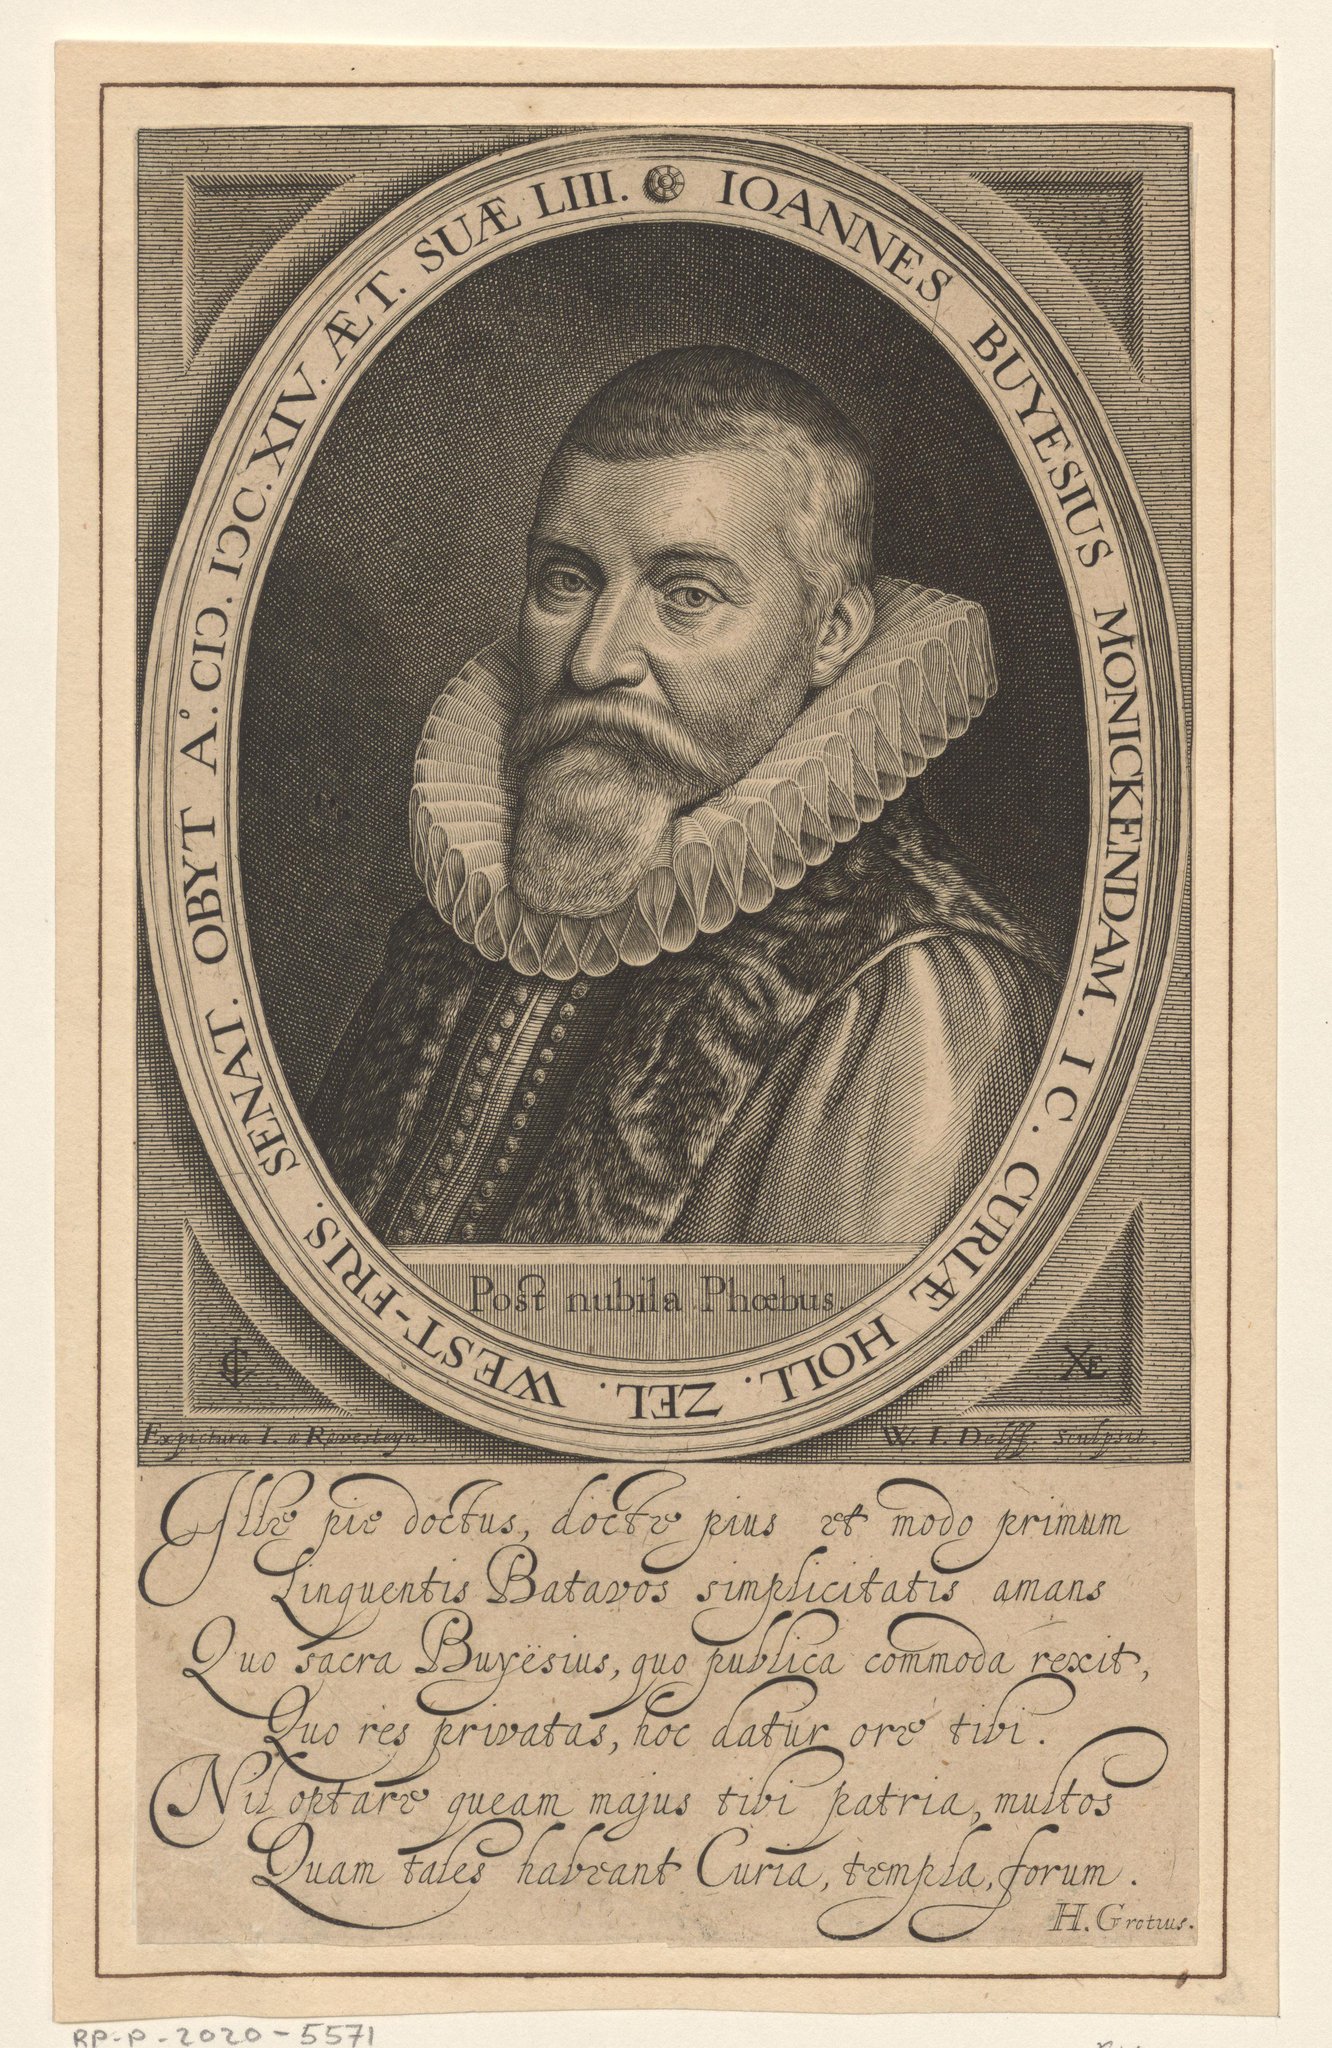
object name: print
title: Portret van Jan Klaasz. Buijes op 53-jarige leeftijd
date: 1614-1638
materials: paper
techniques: engraving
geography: amsterdam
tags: historical persons